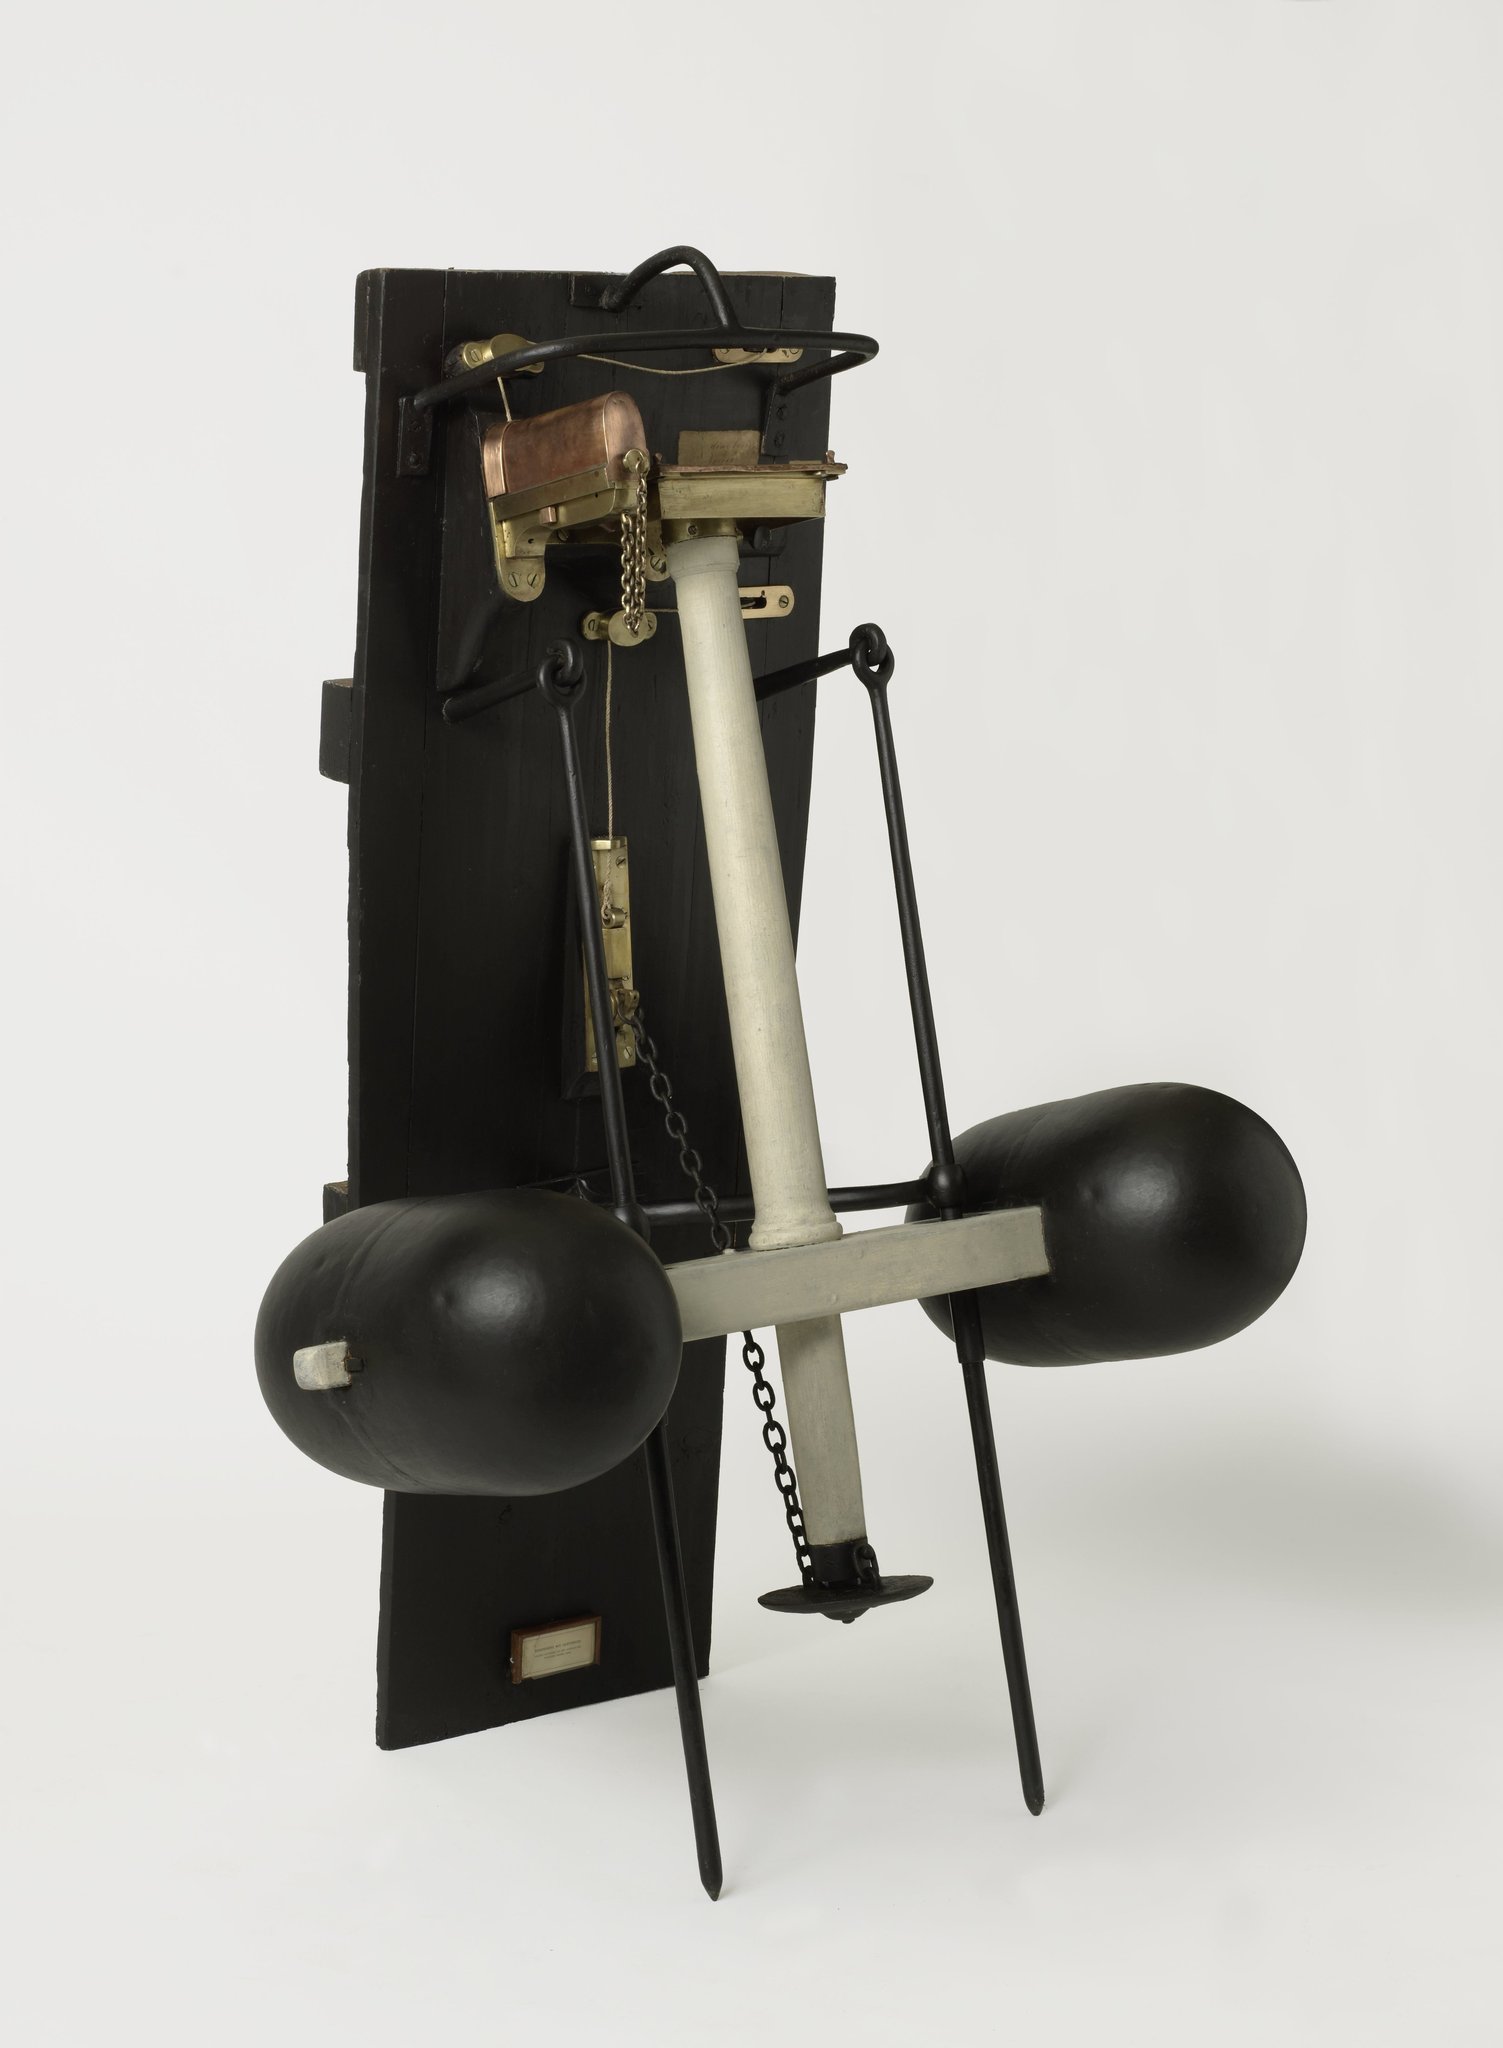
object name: life buoy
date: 1819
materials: brass, stone, iron, fiber, wood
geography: netherlands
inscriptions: inscription, bottom, on a framed label: ‘REEDDINGSBOEI MET LICHTTOESTEL / VOLGENS UITVINDING VAN DEN LUITENANT DER / ENGELSCHE MARINE, Cook.’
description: Reddingstoestel tegen een schuine wand. Het toestel bestaat uit een stel drijvers verbonden door een dwarsbalk met een verticale ronde paal in het midden. Het wordt tegen de wand gehouden met twee geleidestangen door de dwarsbalk en is geborgd met een ketting; de ketting wordt met een sliphaak losgemaakt, die met een touw door de wand wordt bediend, waarna het toestel langs de geleidestangen naar beneden valt en vrij komt. Bovenop de paal is een vuurplaat met lichtgevend vuur aangebracht. Vlak voor het lanceren wordt het vuur aangestoken met een vuursteenslot dat tegen de wand is aangebracht in een messing beschermkap, met een trekkertouw dat over een paar schijven door de wand heen gaat. De deksel van de vuurplaat, die het beschermt tegen vocht, is aan de wand bevestigd en blijft achter na lancering. In het ondereind van de paal is een uitschuifbare ijzeren stang met een ronde plaat aangebracht, die uitschuift zodra het toestel vrijkomt. Een vuurplaat is apart bijgevoegd (NG-MC-1081-B).